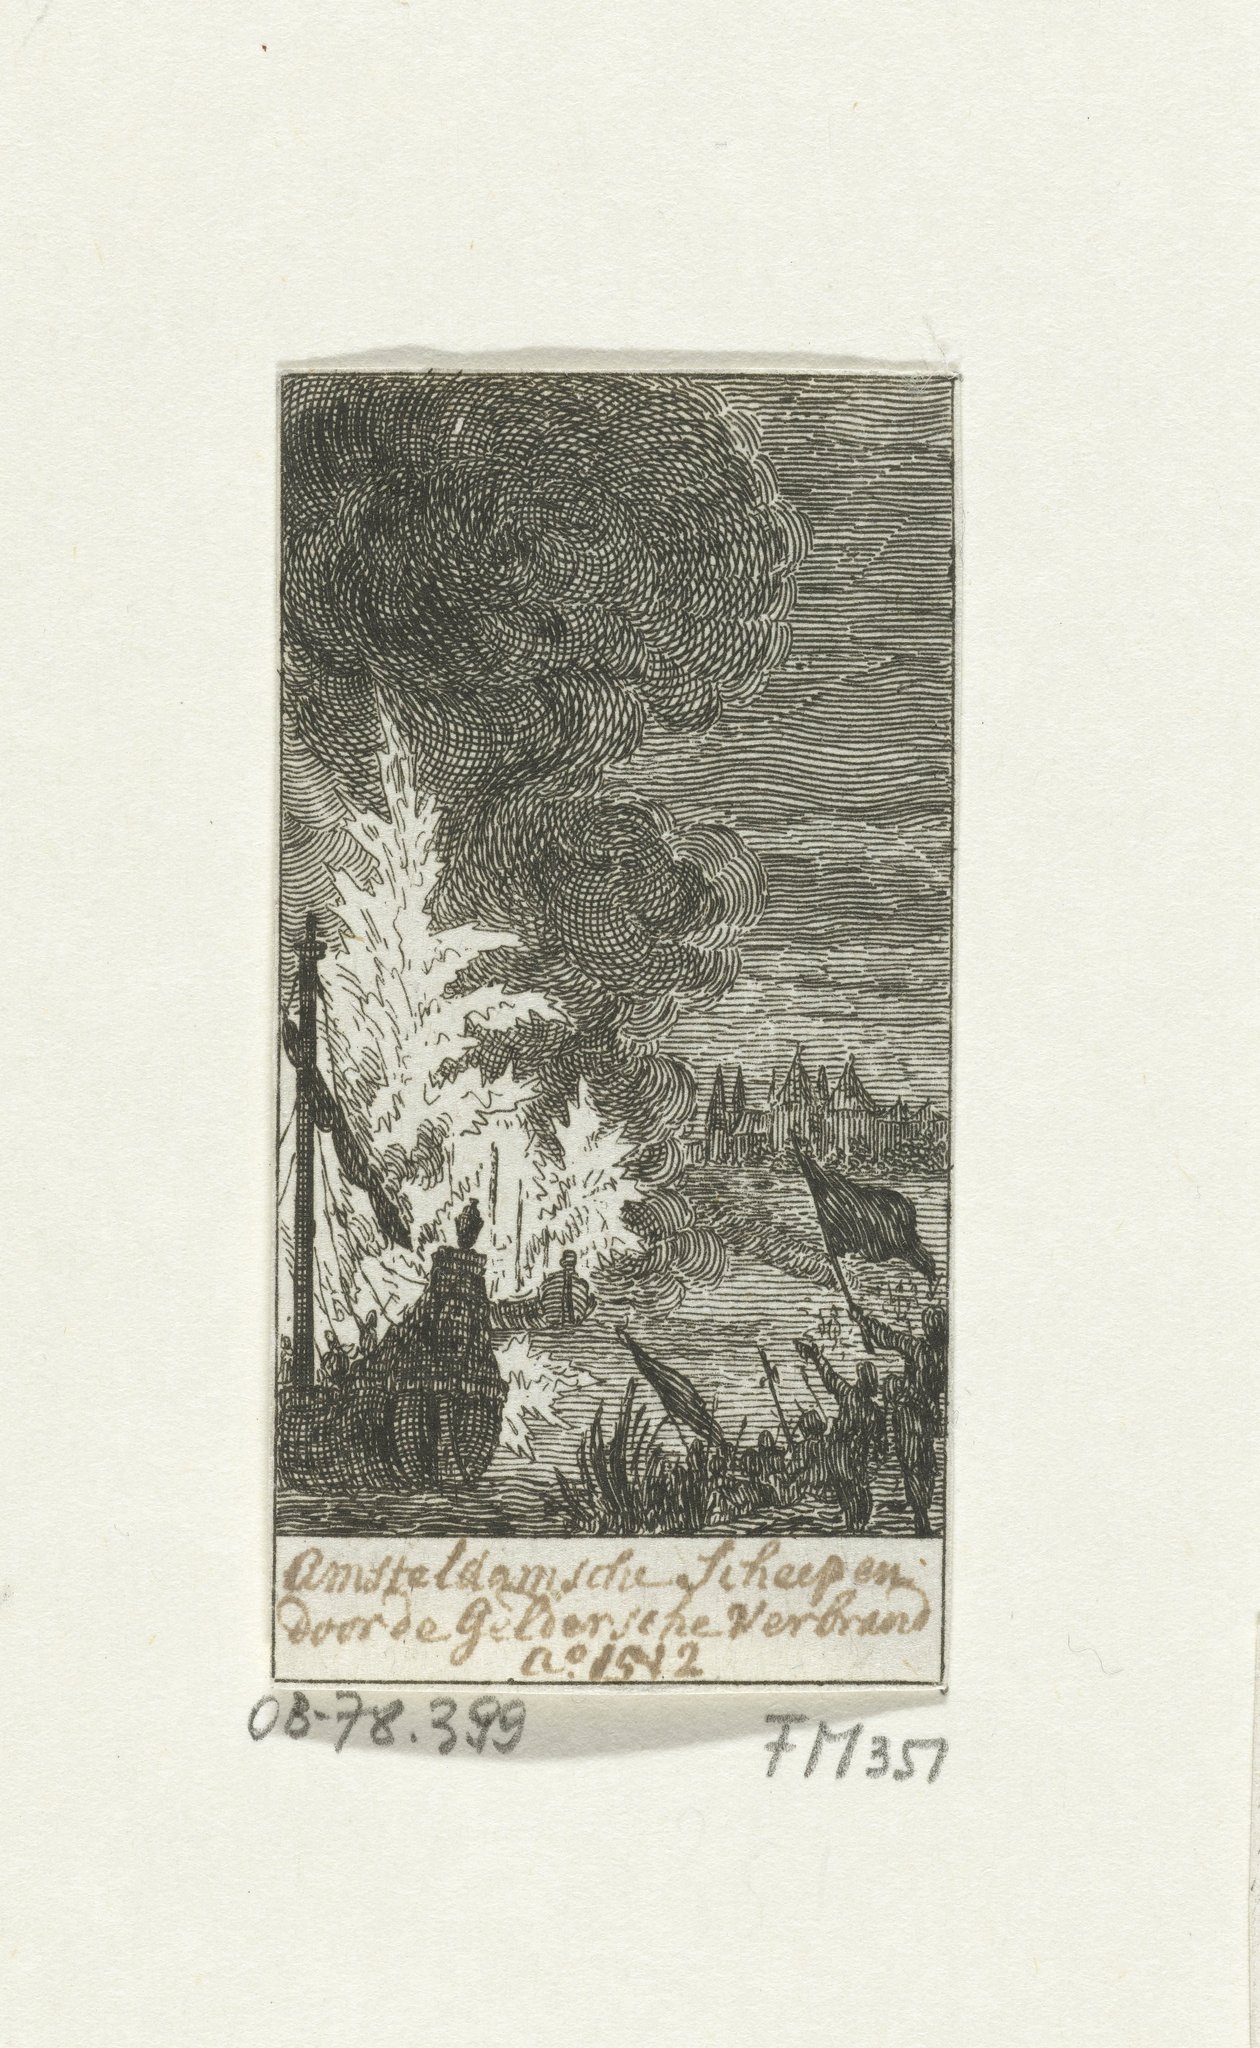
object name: print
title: Amsterdamse schepen door de Geldersen verbrand, 1512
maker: simon fokke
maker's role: draughtsman, print maker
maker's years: 1712-1784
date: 1722-1784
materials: paper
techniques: etching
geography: northern netherlands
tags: battle, fighting in general, amsterdam, guelders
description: Illustratie voor een almanak. Staat vóór de letter. De titel met pen op de prent geschreven.